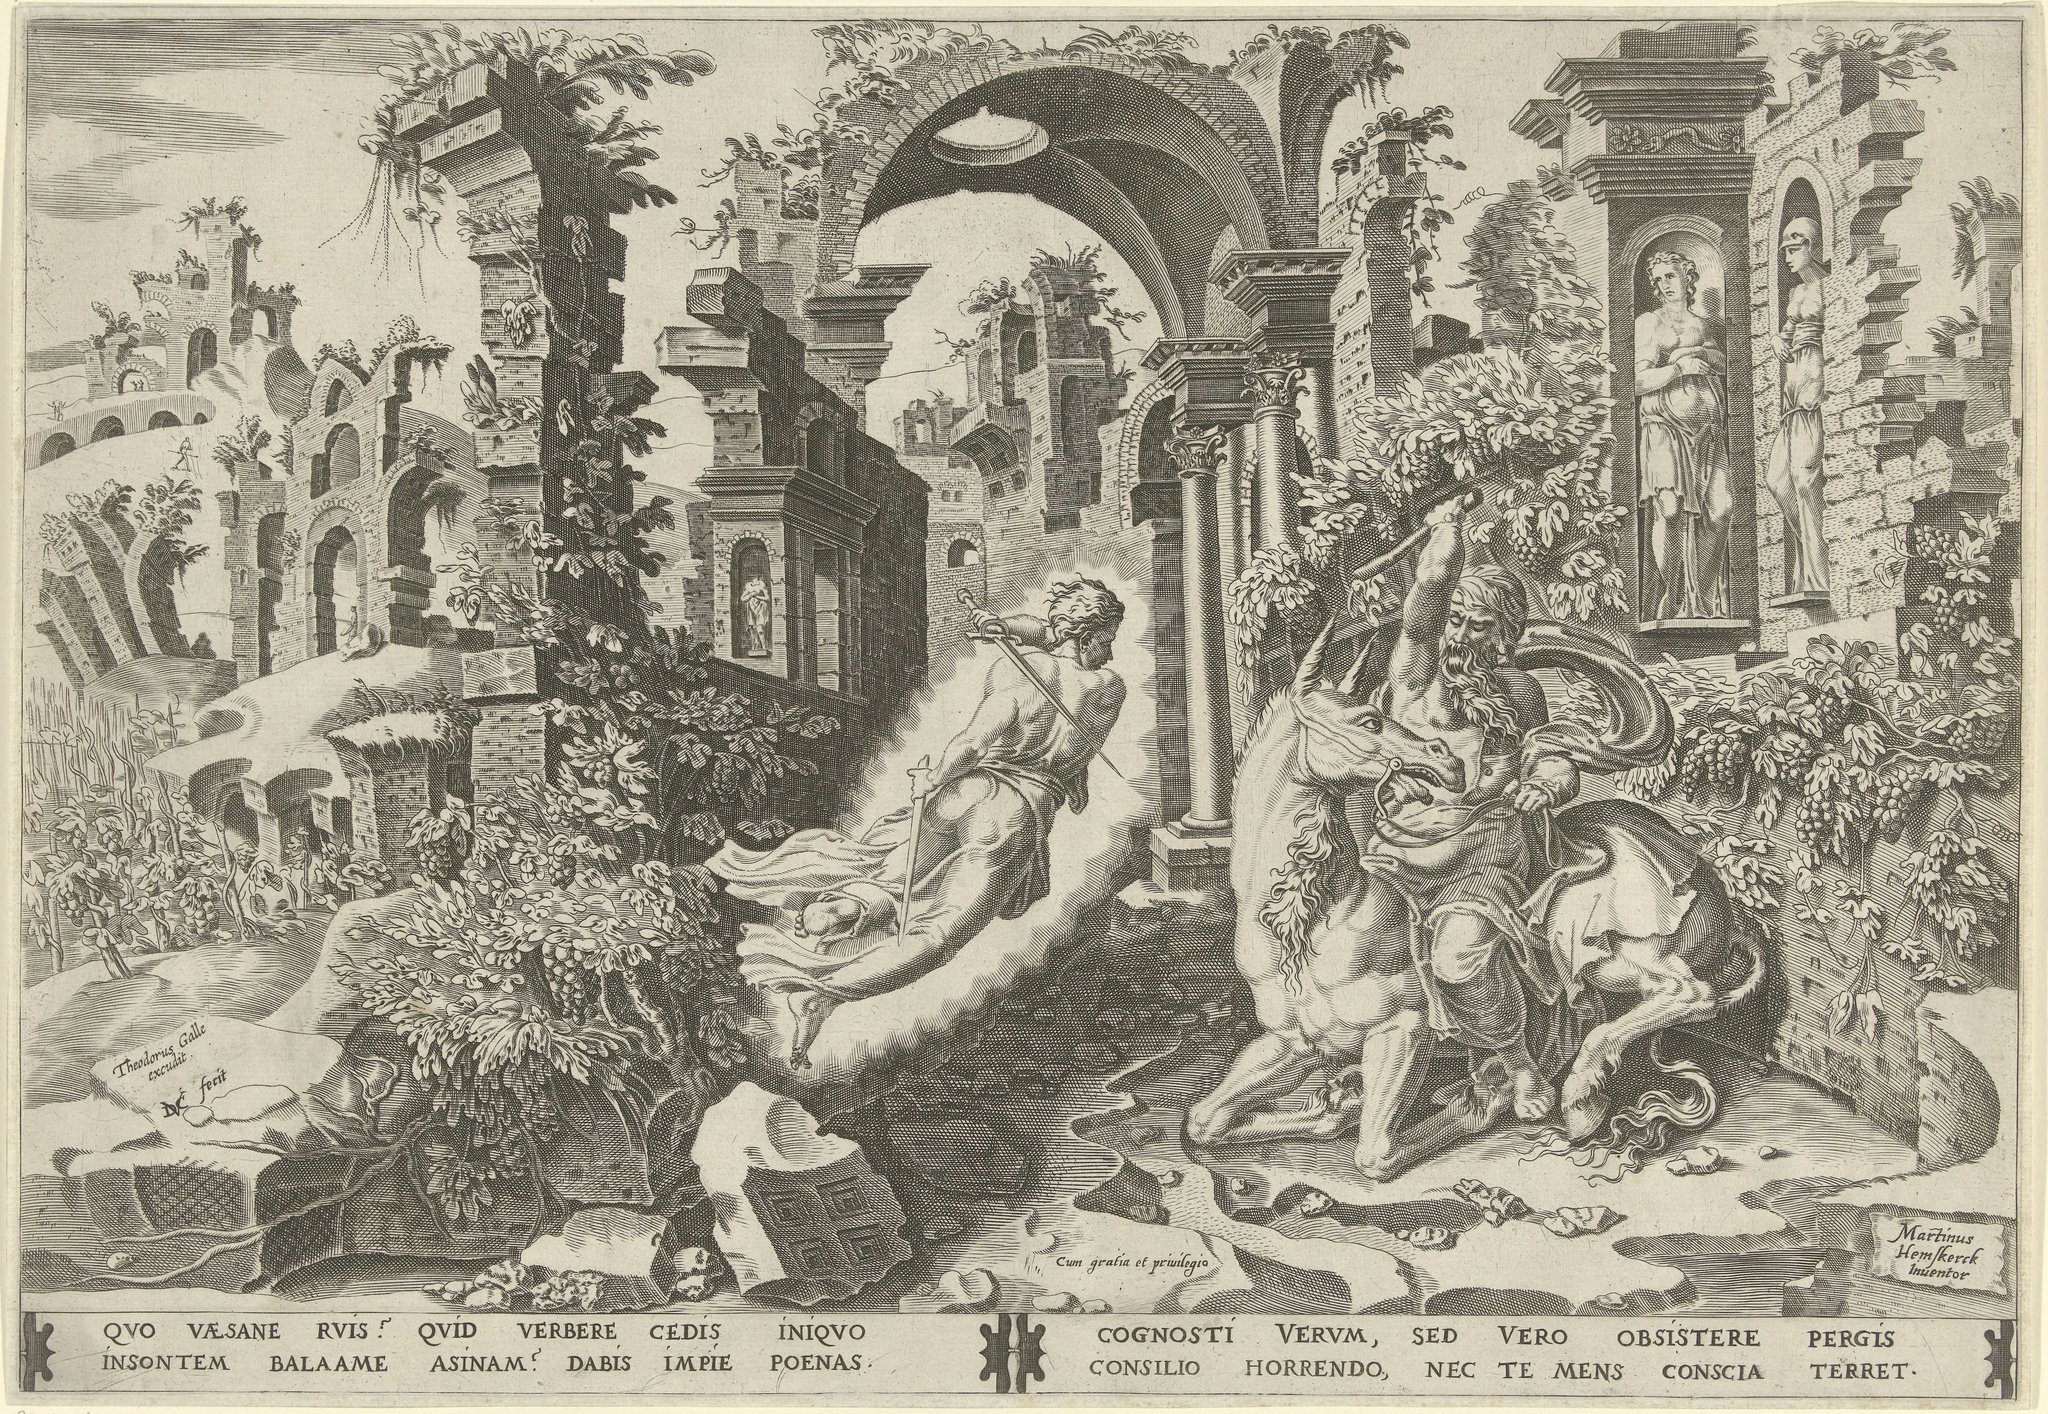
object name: print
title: Bileam (Balaäm) en de engel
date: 1581-1633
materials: paper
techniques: engraving, etching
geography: antwerp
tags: landscape with ruins, an angel holding a sword bars the way and causes balaam's ass to turn aside; the angel is invisible to balaam, balaam strikes his ass, whereupon the ass lies down and starts to speak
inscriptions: collector's mark: Lugt 2228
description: Een landschap met een ruïne. Centraal Bileam op zijn ezel. De ezel van Bileam weigert verder te gaan omdat een engel met een zwaard het dier bedreigt. Bileam slaat zijn ezel met een stok. De prent heeft een Latijns onderschrift